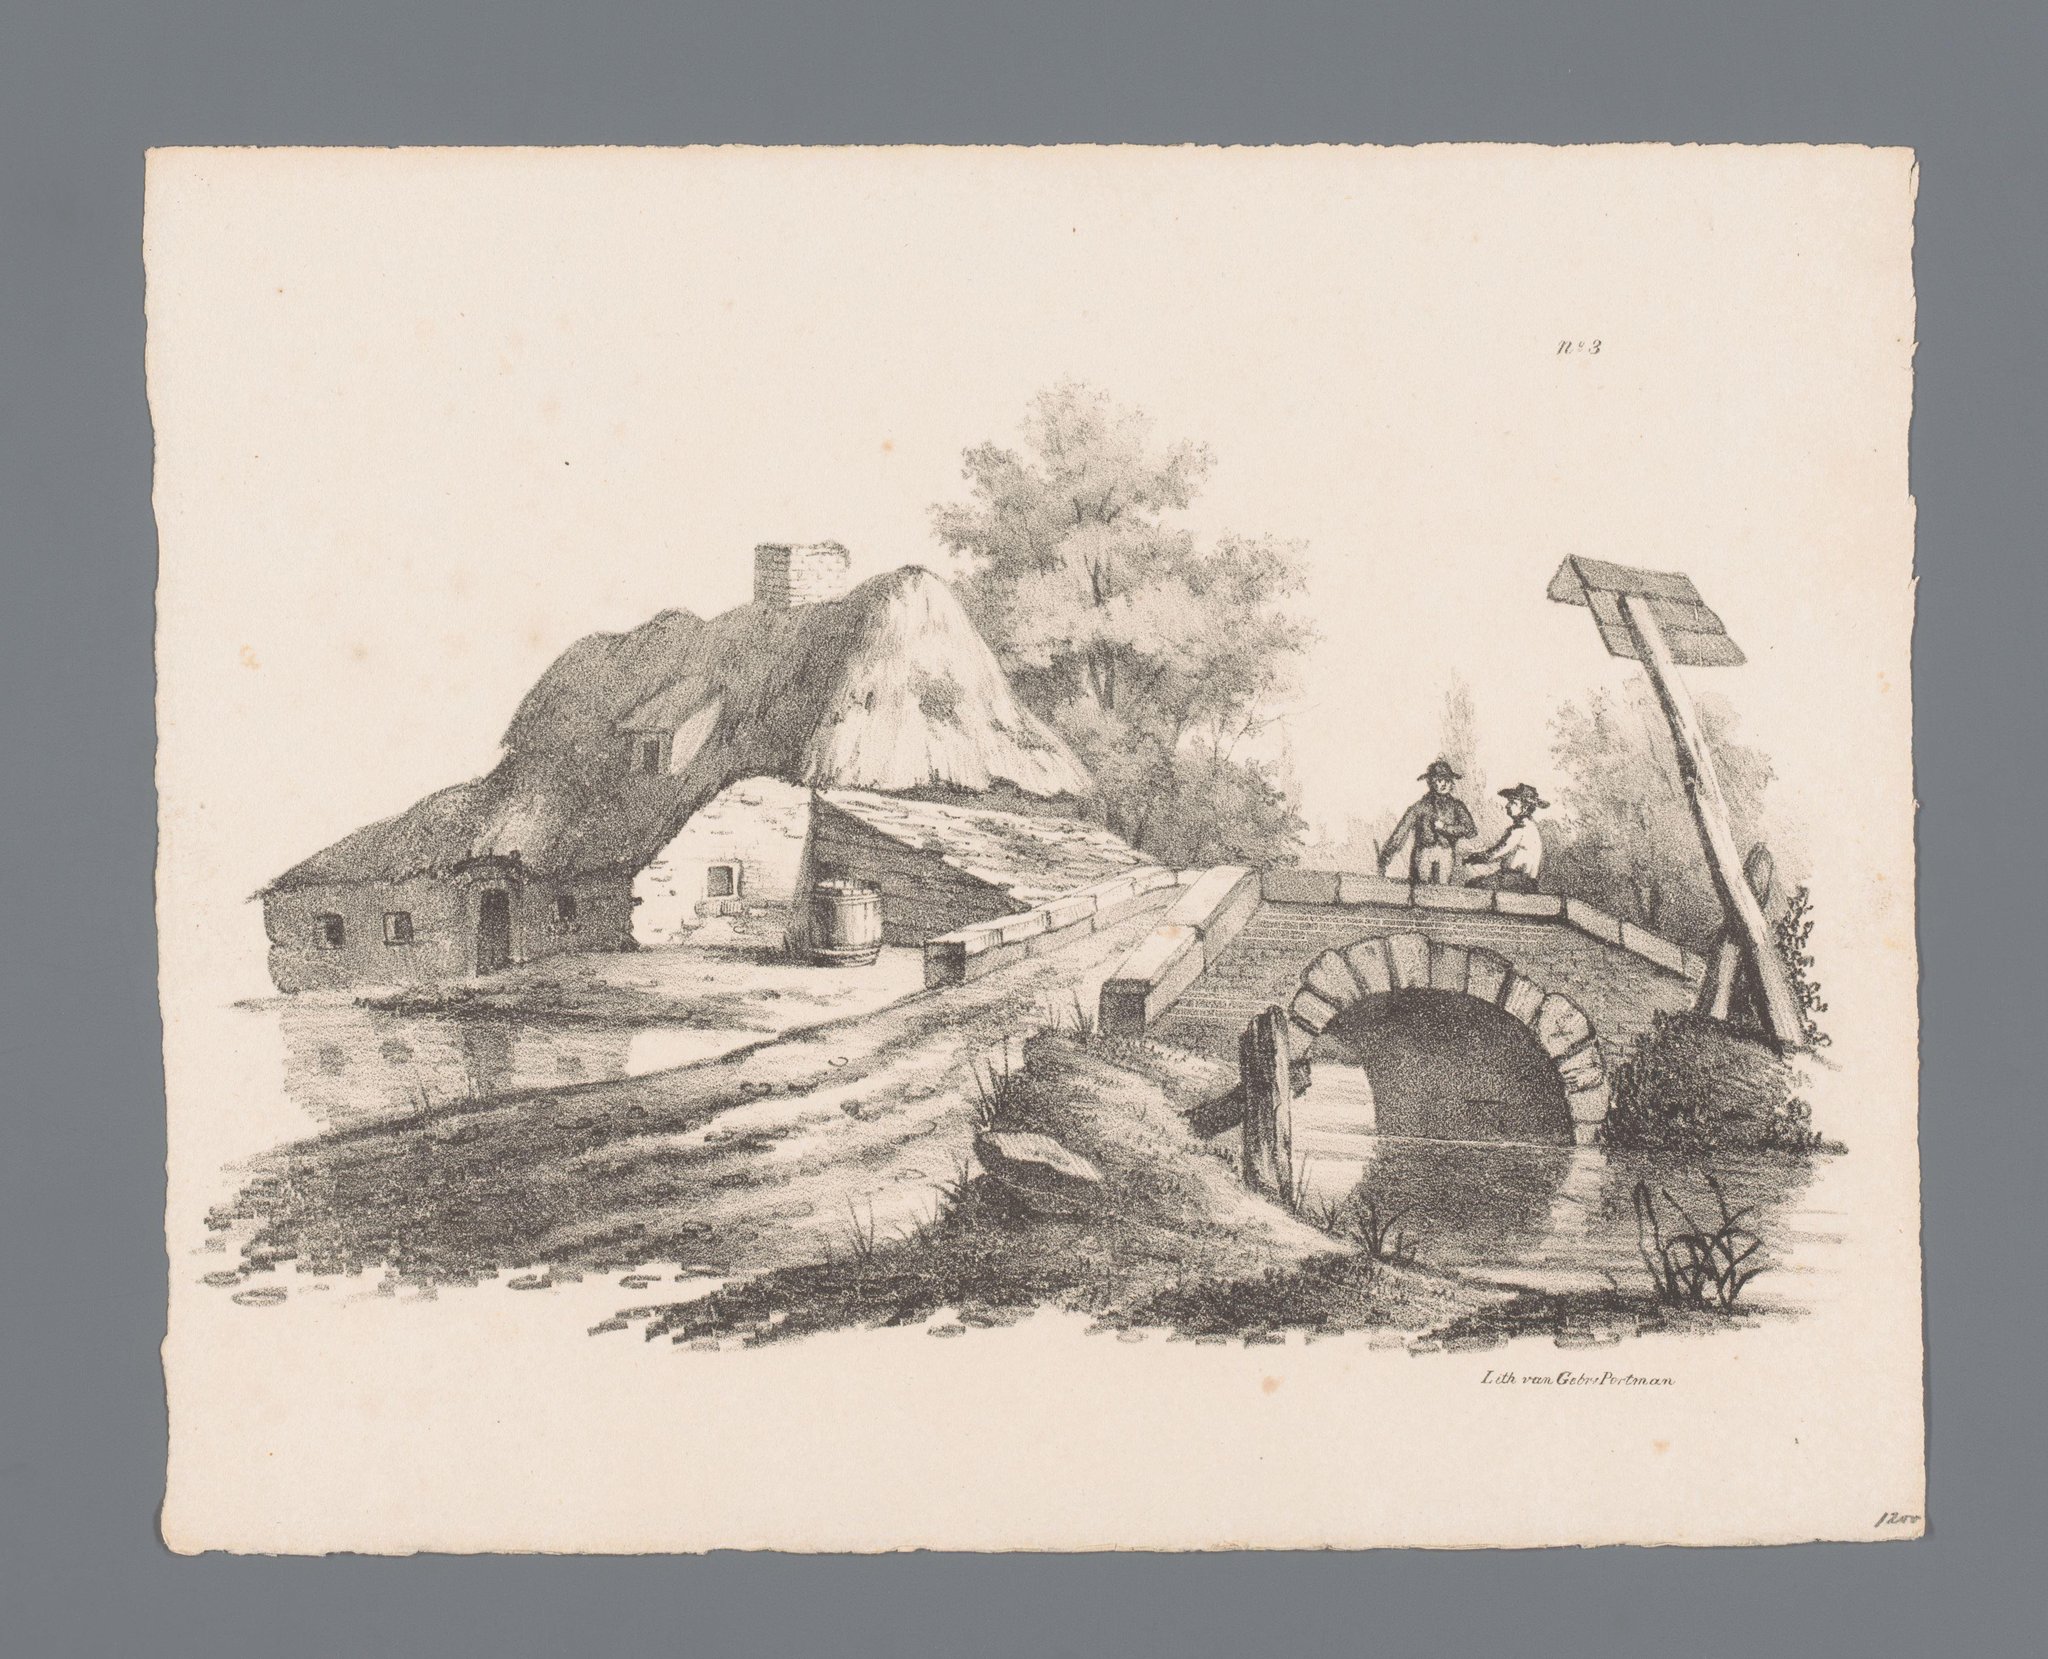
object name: print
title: Boerderij en stenen brug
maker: cornelis de kruyff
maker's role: draughtsman, print maker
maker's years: 1774-1828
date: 1827-1828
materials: paper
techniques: lithograph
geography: amsterdam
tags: landscape with bridge, viaduct or aqueduct, farm or solitary house in landscape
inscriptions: collector's mark: Lugt 2228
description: Op de brug staan twee figuren. Genummerd rechtsboven: No. 3. Deze prent maakt deel uit van een omslag met dertien prenten.